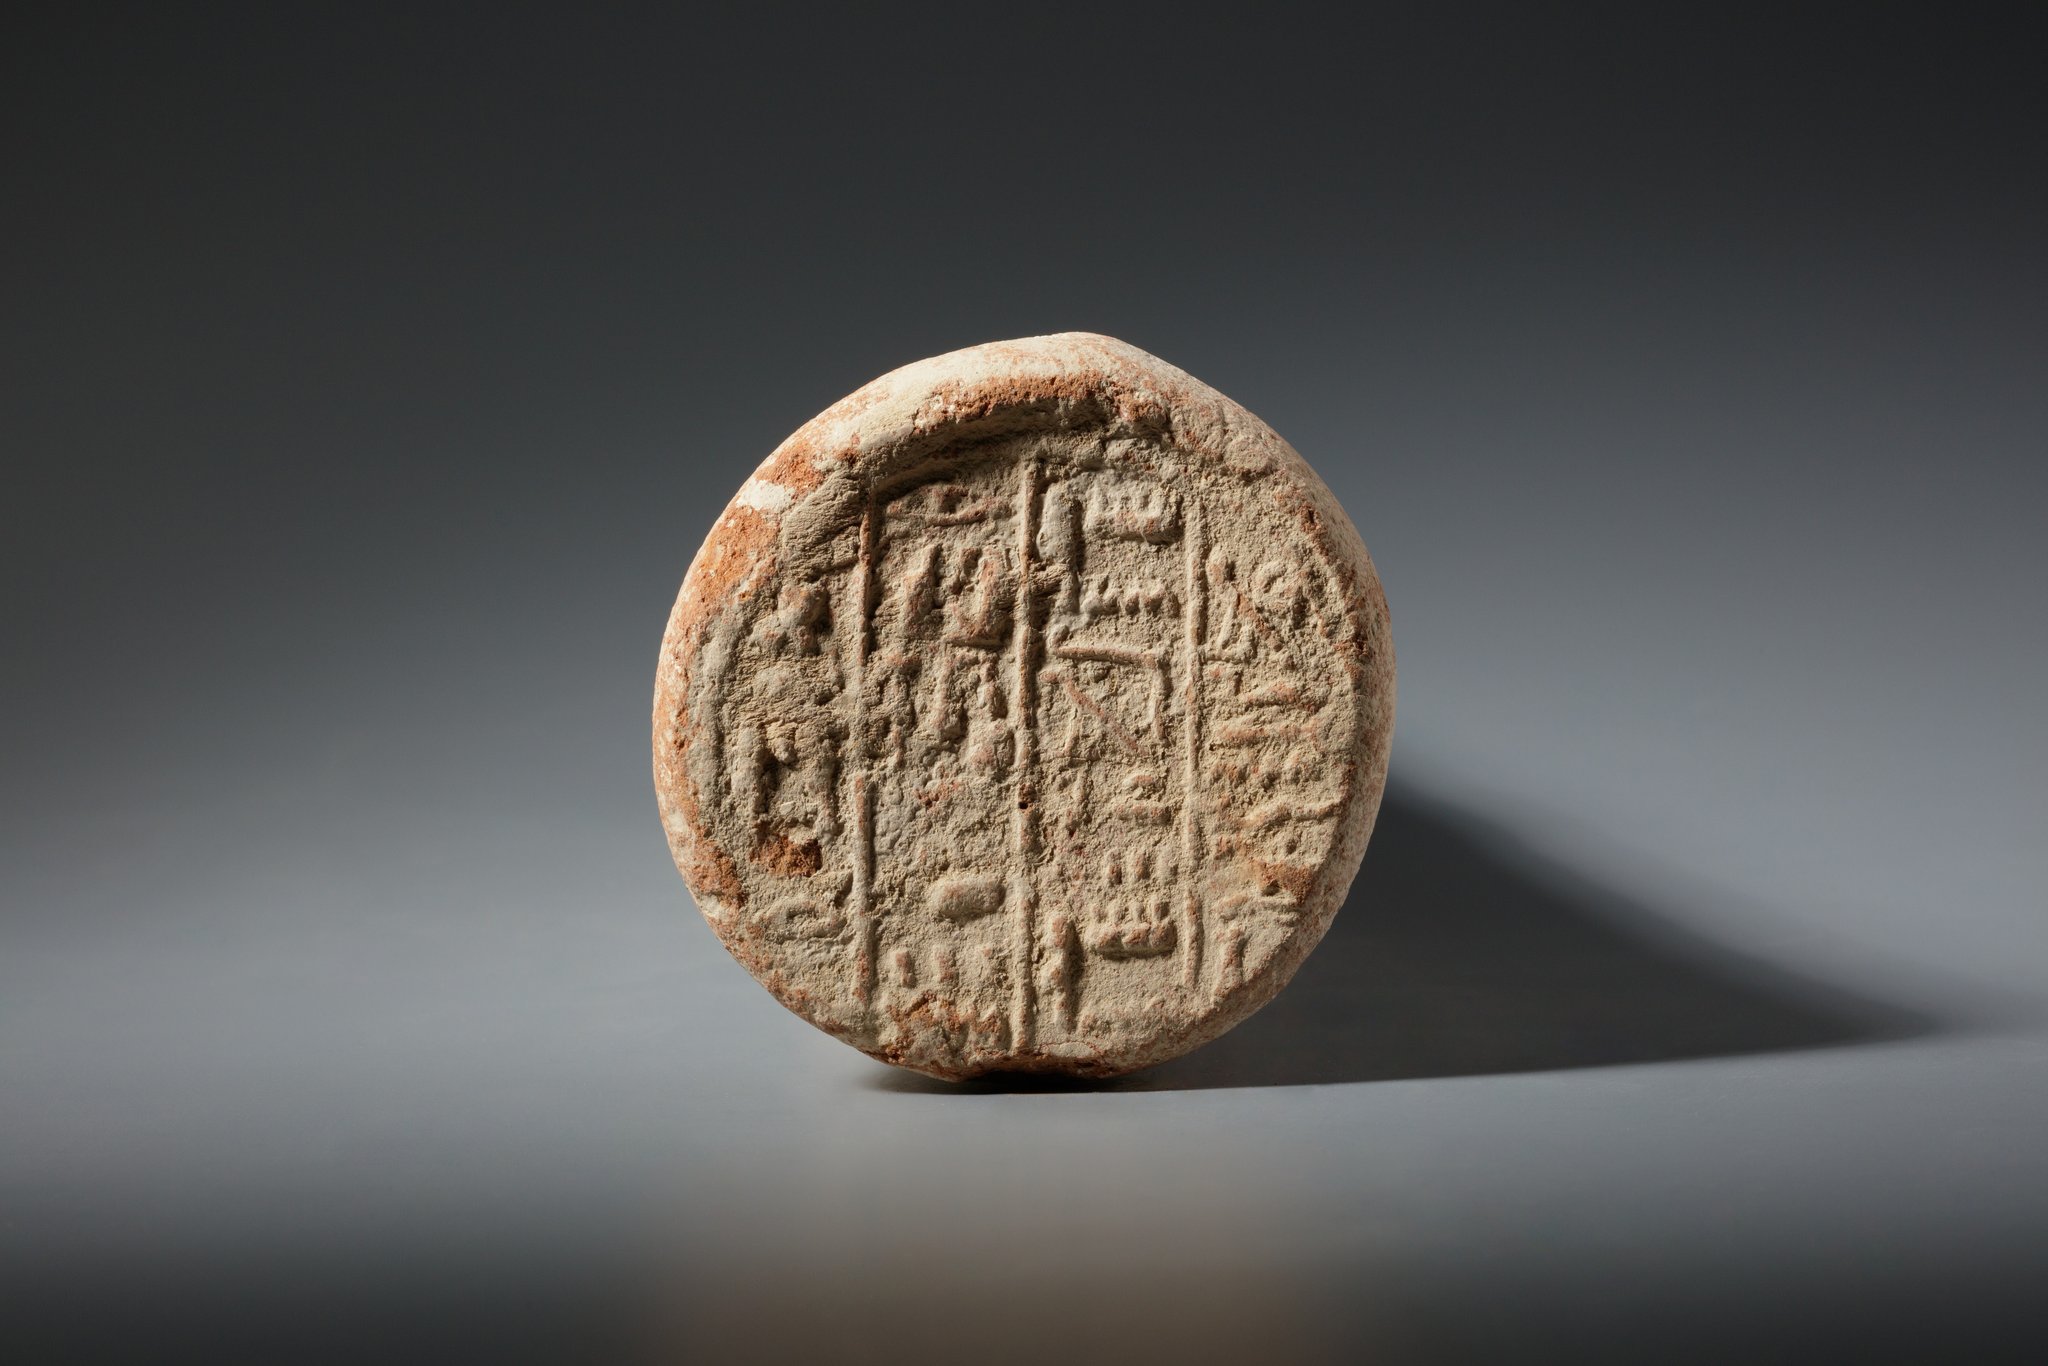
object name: cone, davy 73, amenemopet, tjanefer, scribe, grain, amun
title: Funerary Cone of the Scribe Amenemopet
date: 1400-1352 BCE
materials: pottery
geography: egypt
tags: hieroglyphs